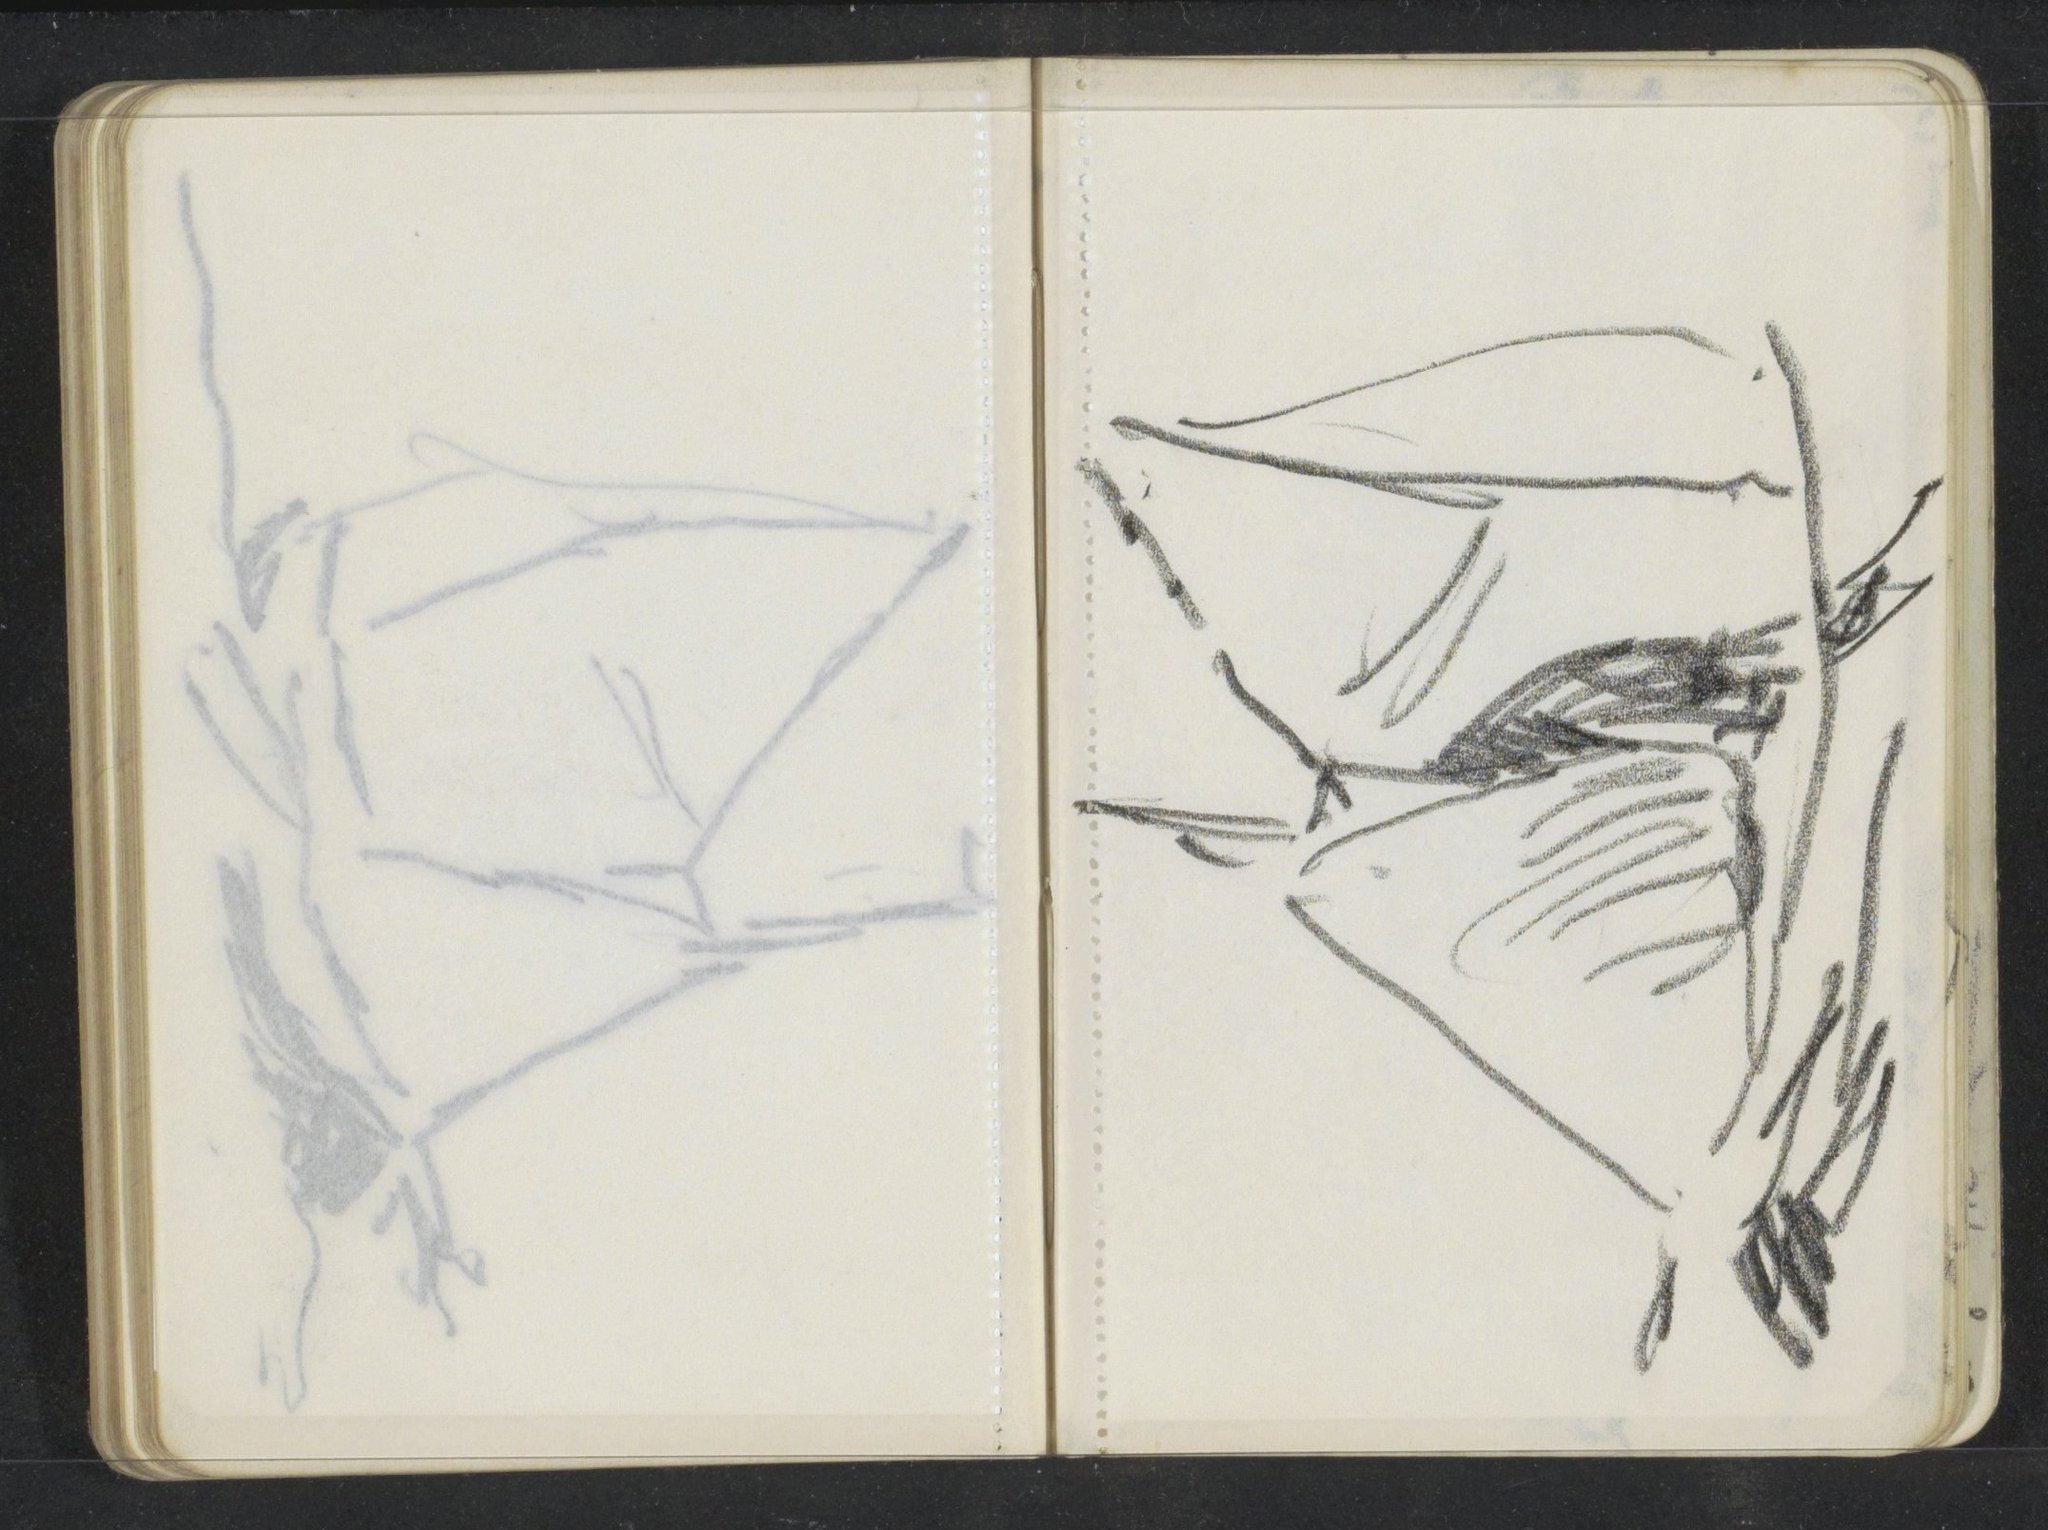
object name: sketchbook leaf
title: Zeilboot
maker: alexander shilling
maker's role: draughtsman, print maker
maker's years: 1859-1937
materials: paper, pencil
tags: sailing-ship, sailing-boat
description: Blad 58 recto uit een schetsboek met 91 bladen.